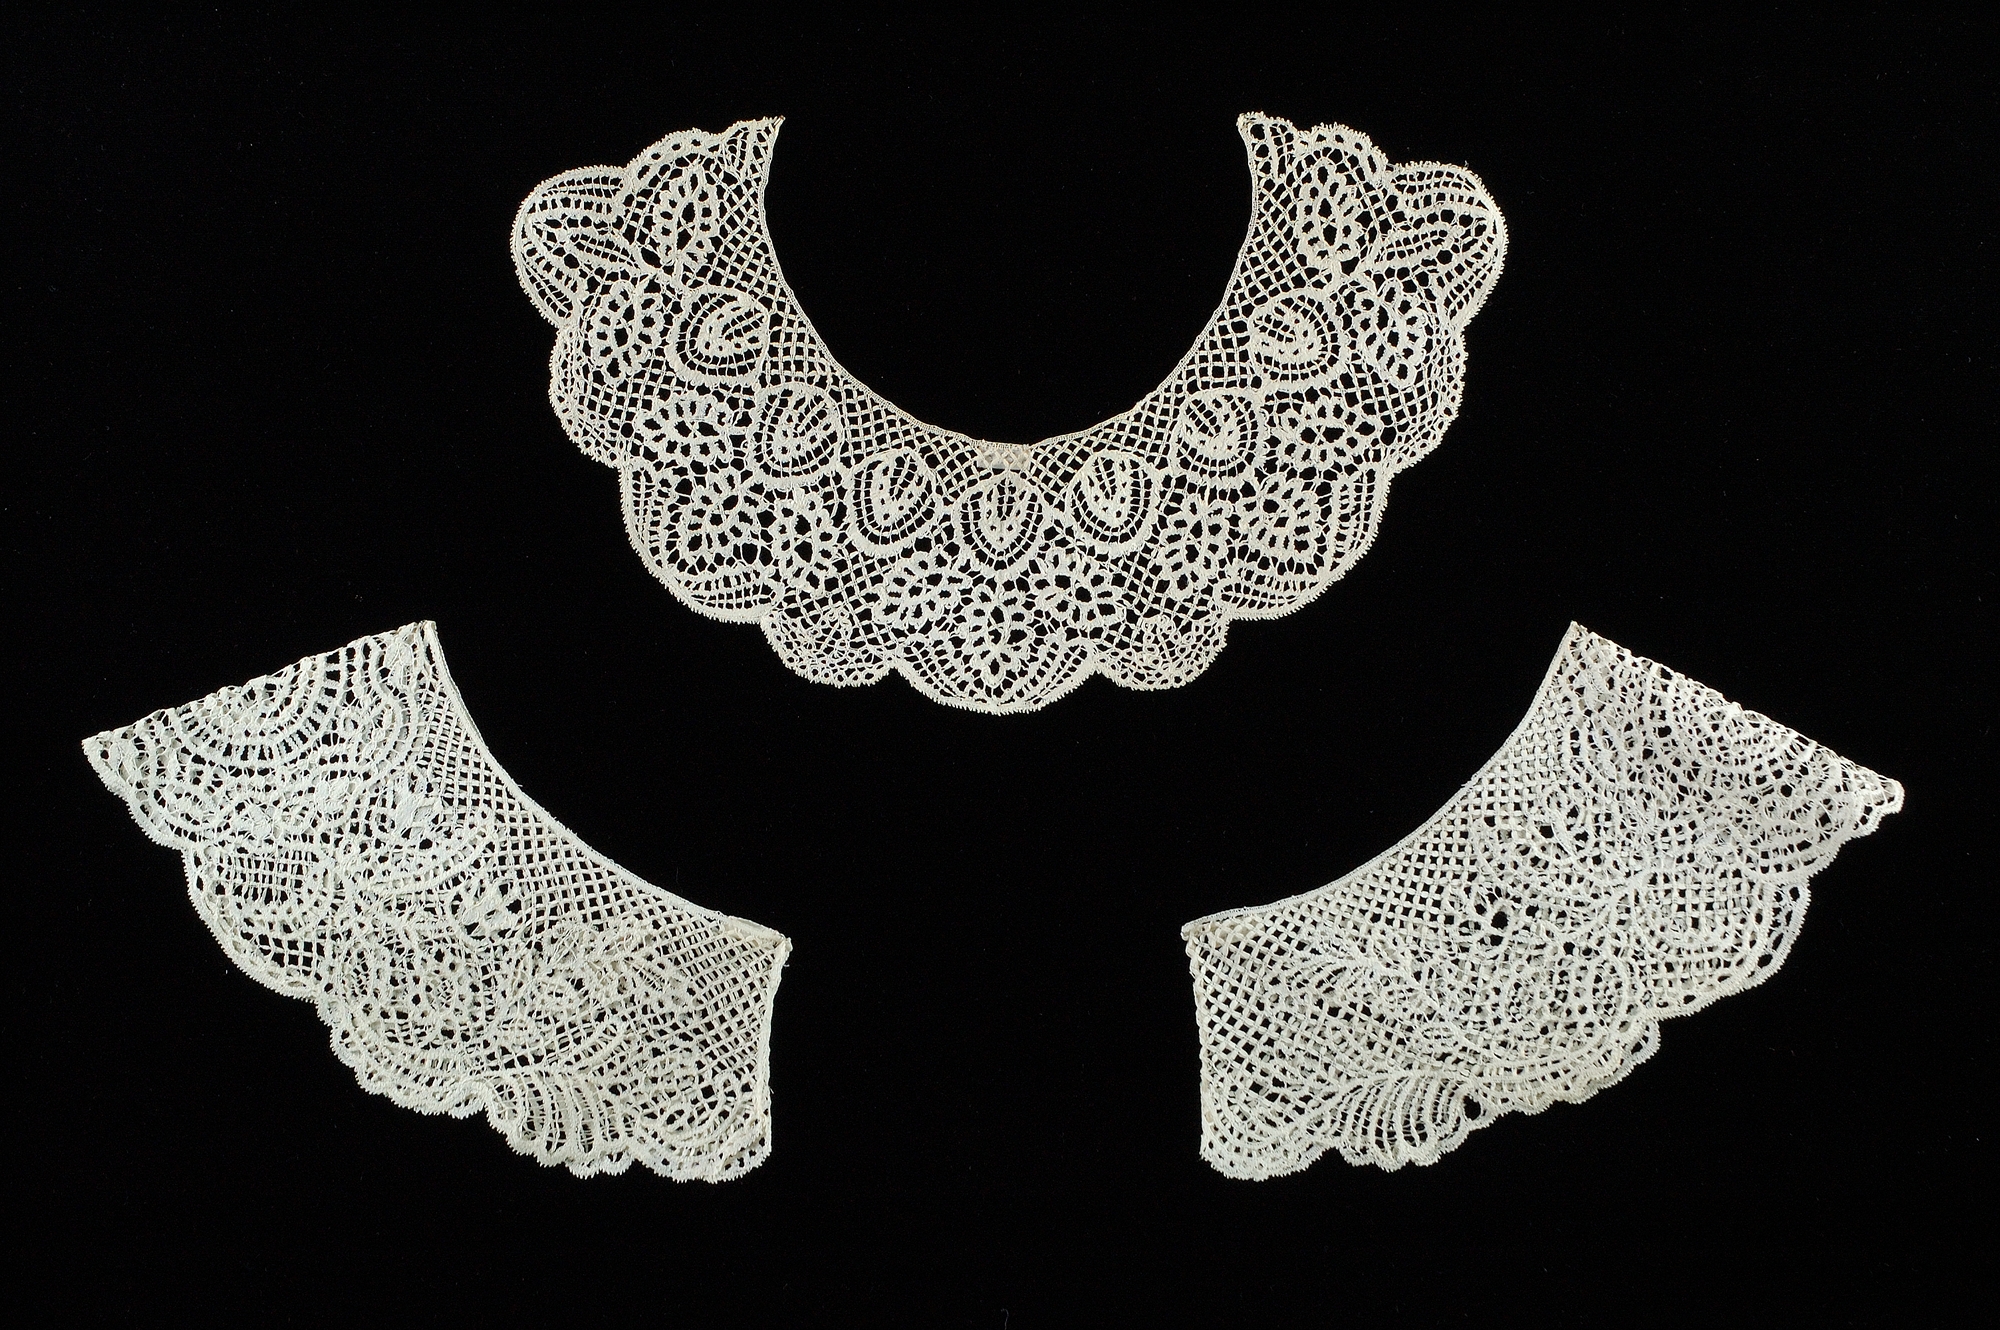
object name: accessory set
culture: british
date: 1850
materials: linen